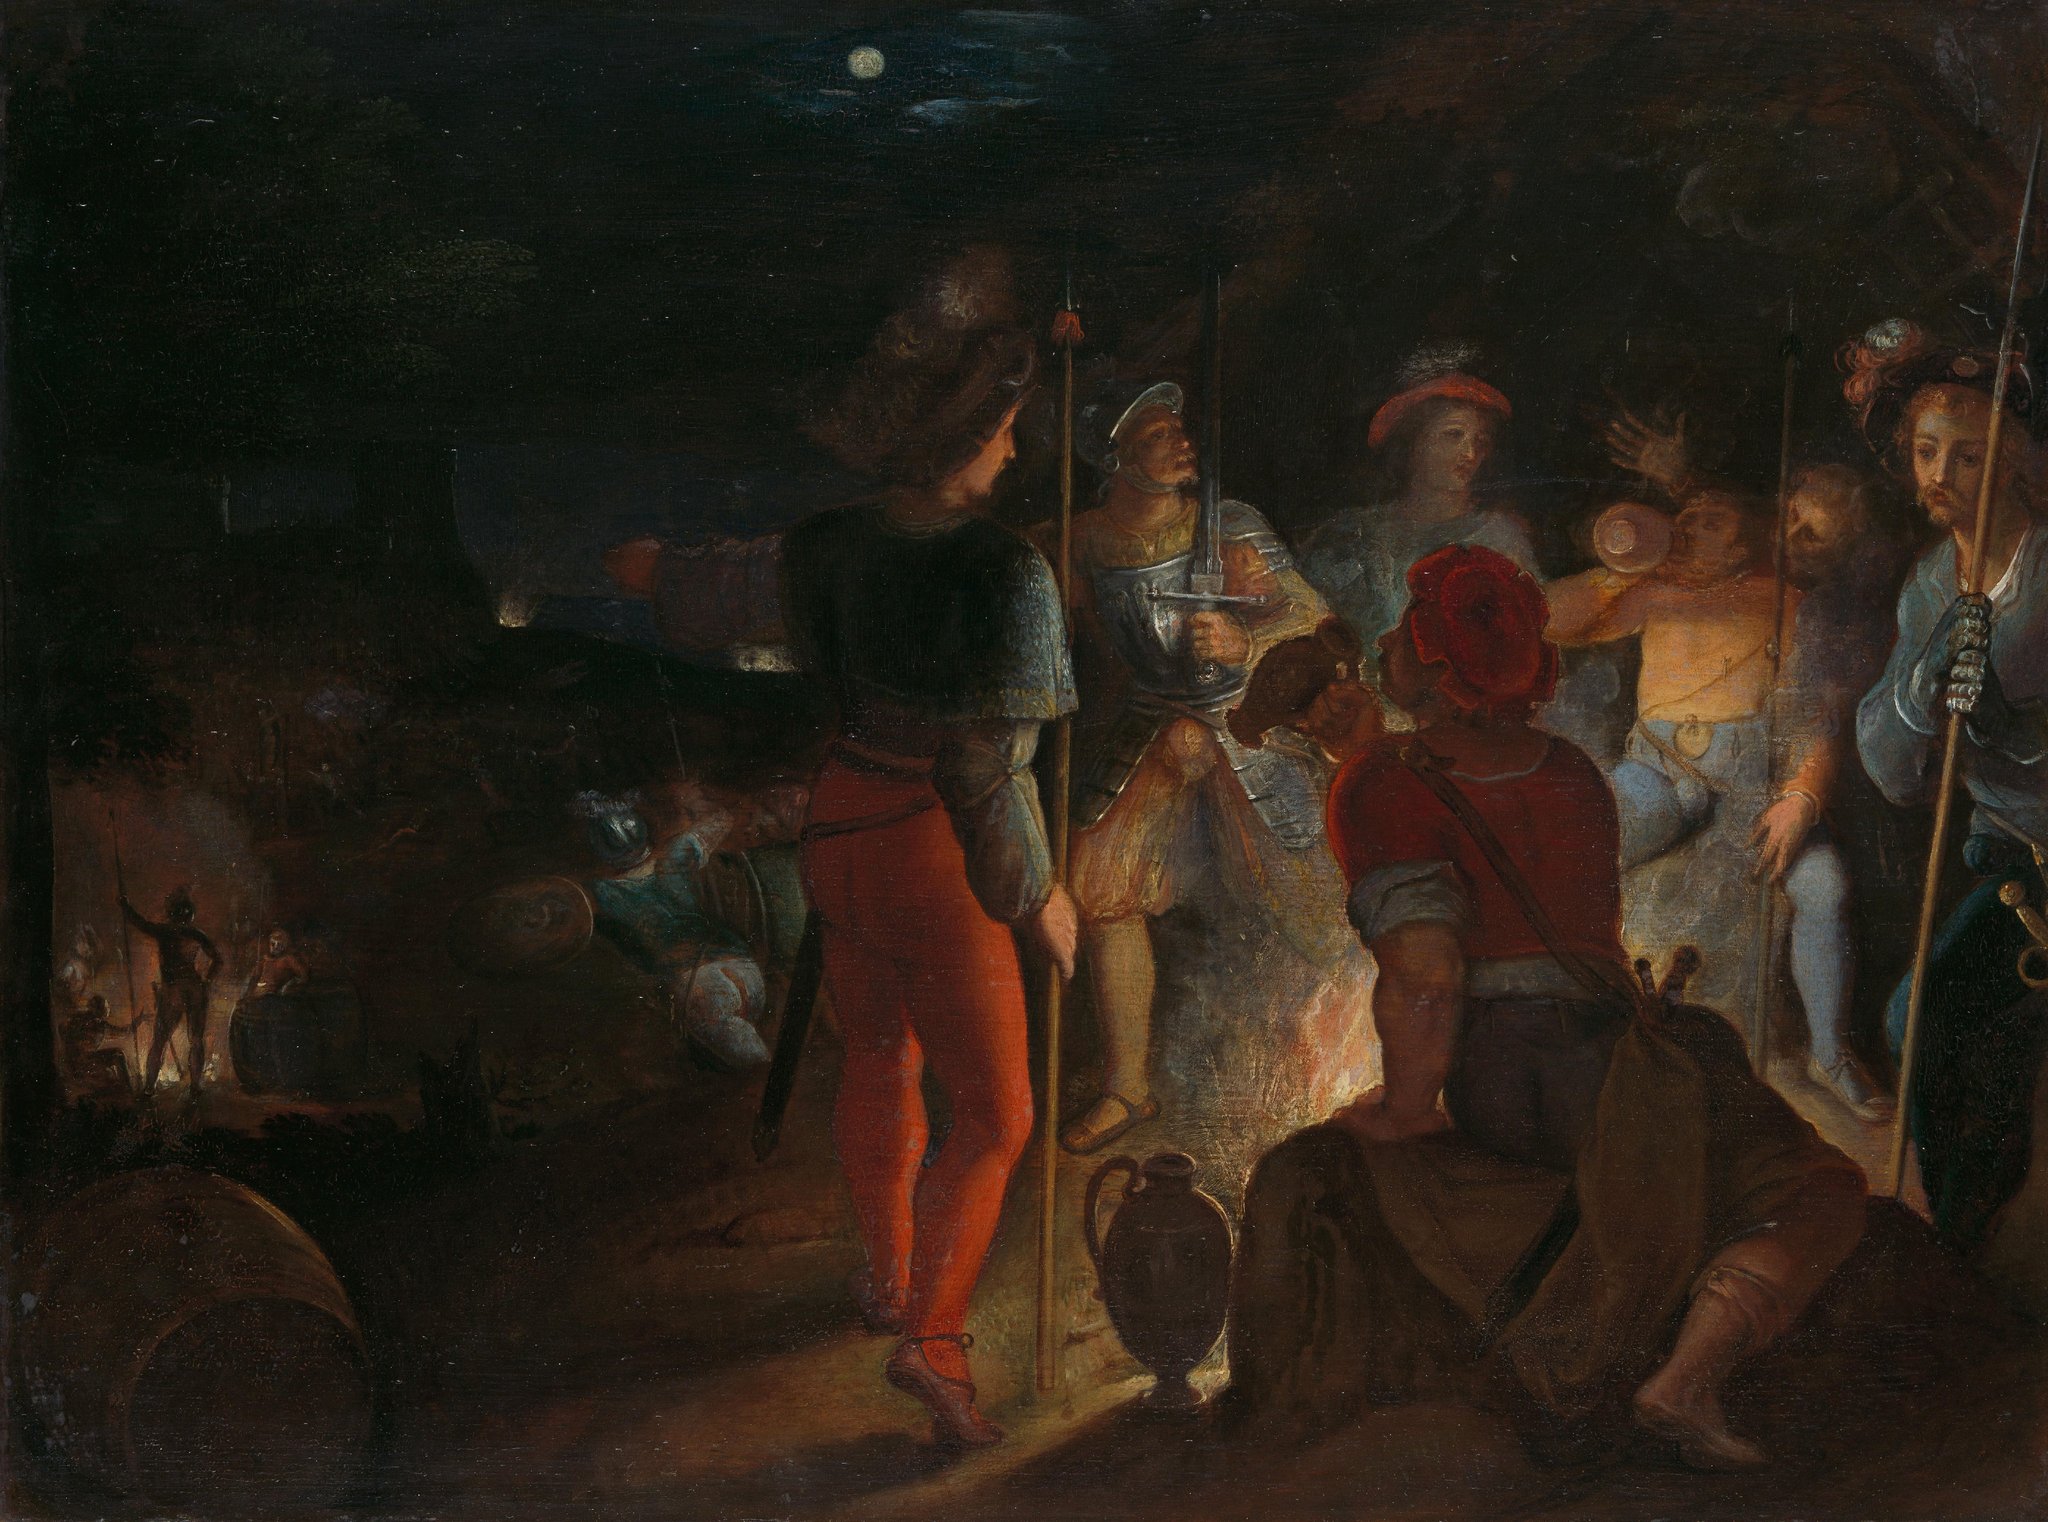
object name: painting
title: "Claudius Civilis Besieges the Romans in Vetera Castra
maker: otto van veen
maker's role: draughtsman, painter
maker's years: 1556-1629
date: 1600-1613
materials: oil, panel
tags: siege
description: In 1613, the Dutch parliament (States General) commissioned Otto van Veen to paint twelve paintings depicting the revolt of the Batavians against the Romans in AD 69 and 70. These were displayed in Binnenhof, the central government building in The Hague. In the early years of the Dutch Republic, many compared their own revolt against Spain to the Batavian uprising.